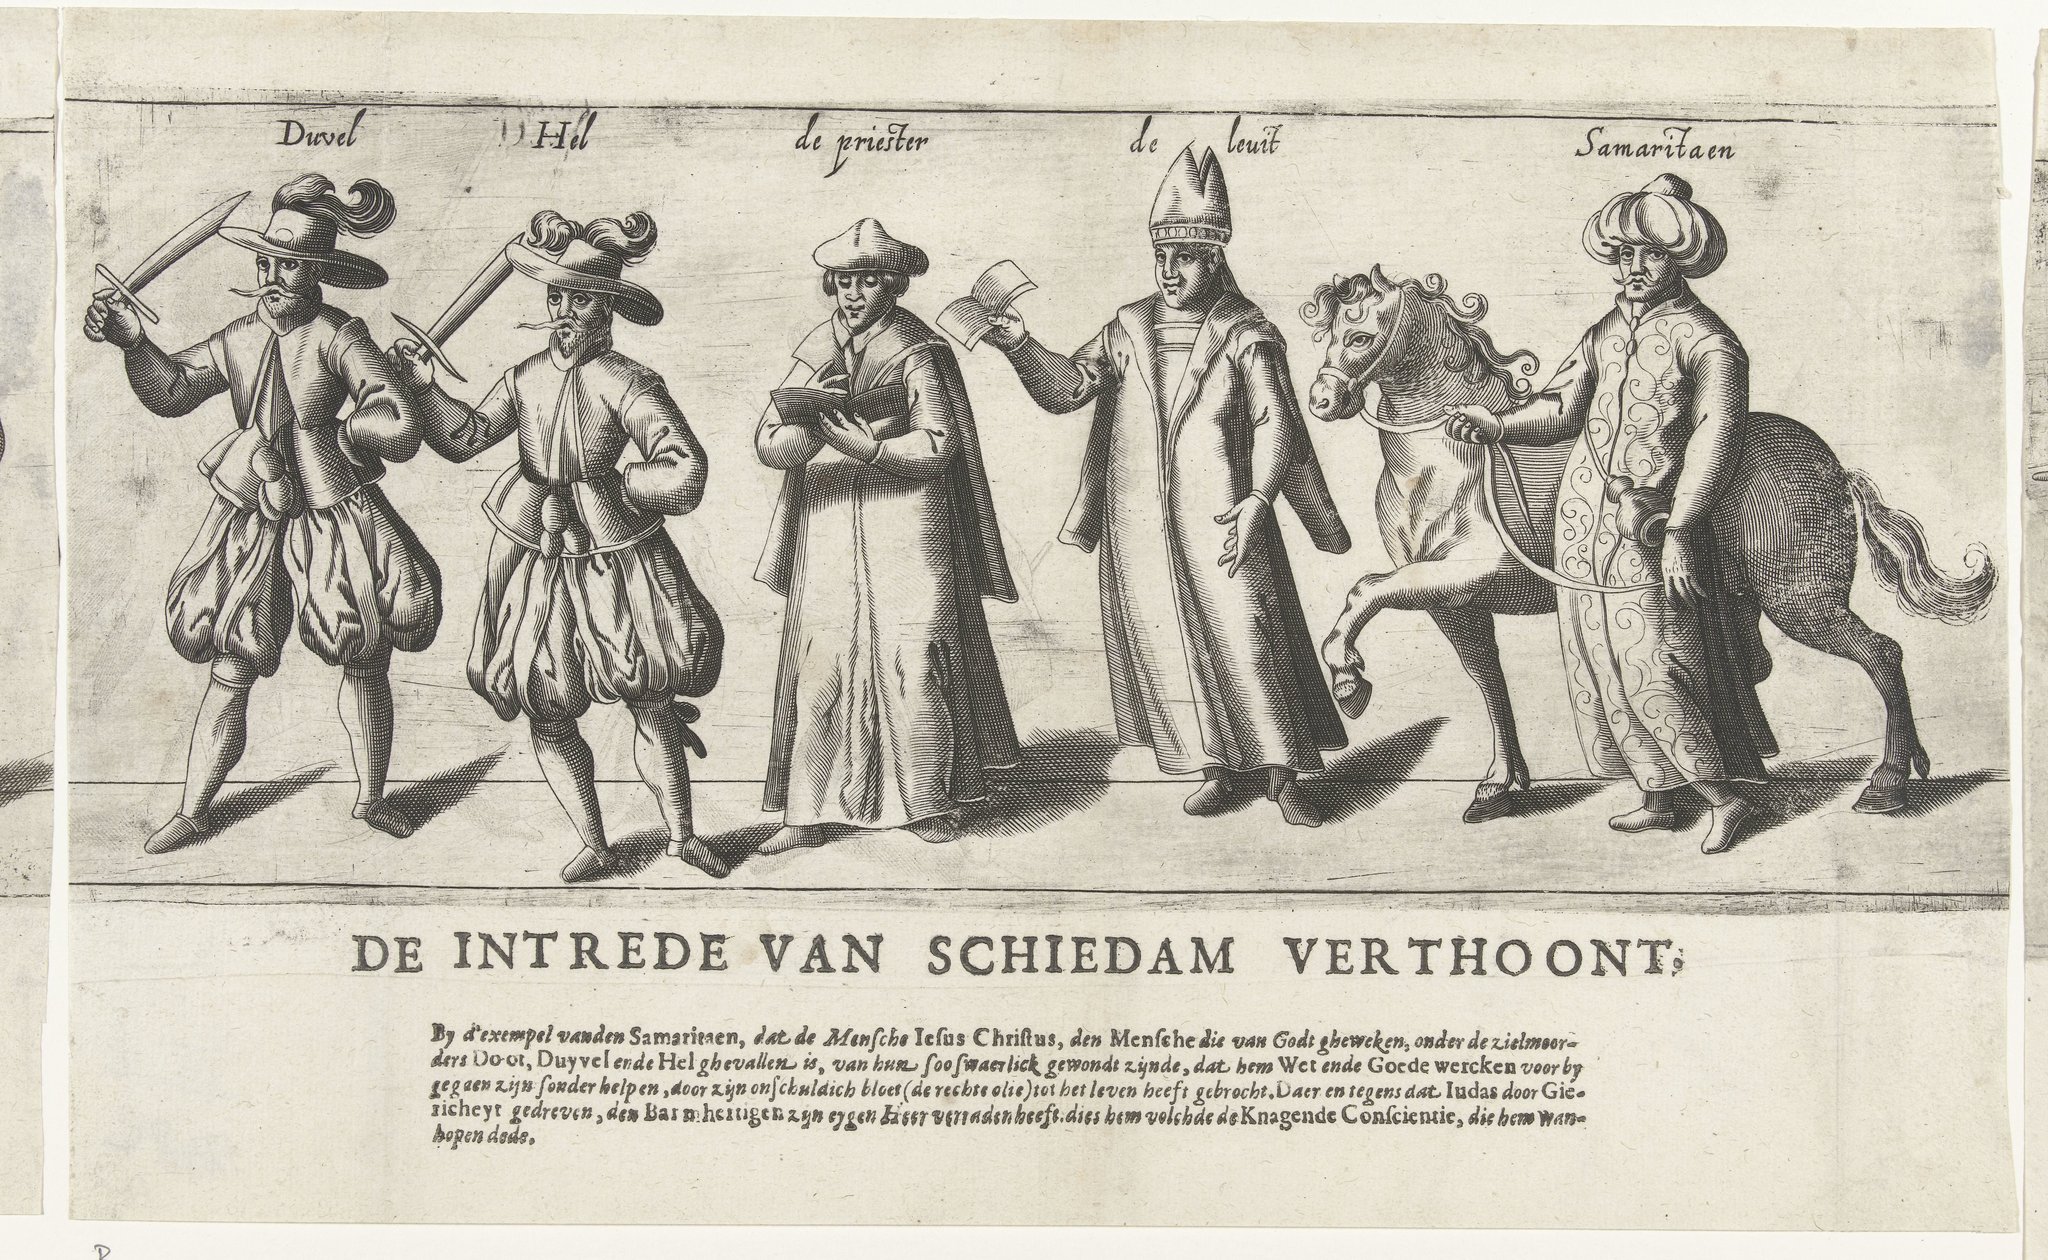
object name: print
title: De intrede van Schiedam verthoont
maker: Anonymous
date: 1607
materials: paper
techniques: engraving, letterpress printing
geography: northern netherlands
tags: the good samaritan (luke 10:30-37), chamber of rhetoric (dutch: 'rederijkerskamer'), festivities (+ parade, pageant, cavalcade ~ festive activities), haarlem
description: Gebruikt als illustratie in: Const-thoonende ivweel, by de loflijcke stadt Haerlem, ten versoecke van Trou moet blijcken, in't licht gebracht. : Waer inne duydelick verclaert ende verthoont wordt alles wat den mensche mach wecken om den armen te troosten, ende zijnen naesten by te staen. : In twaelf spelen van sinne ... in redenrijck naar de volgende voorgegevene caerte van 't speel-korenken, Zacharias Heyns, Zwolle 1607. Los fragment, bedoeld om samen met de andere delen tot een fries gemonteerd te worden.